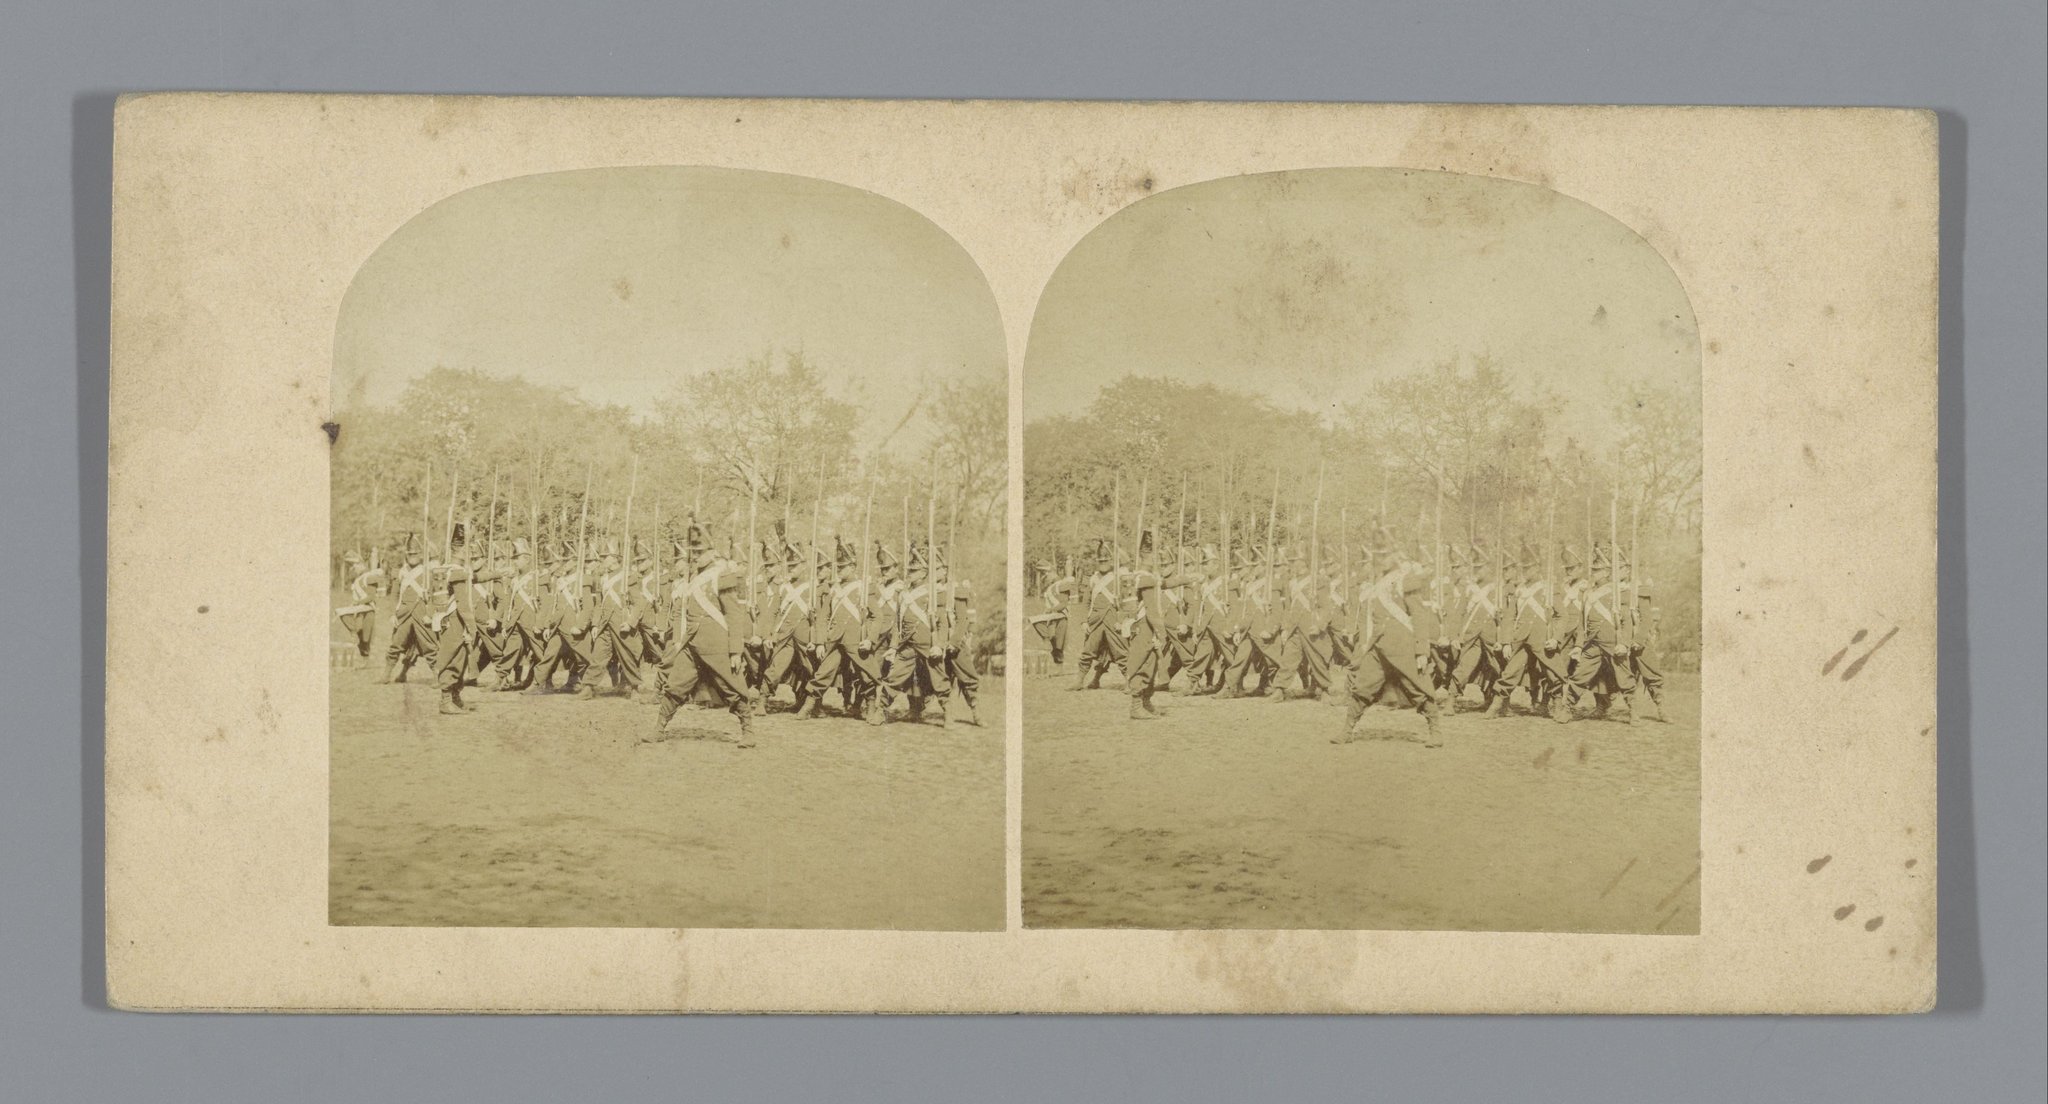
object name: stereograph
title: Marcherende Franse soldaten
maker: Anonymous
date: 1860-1880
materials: cardboard, photographic support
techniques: albumen print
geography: france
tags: marching away (troops), private soldier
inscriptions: number: ‘183’, inscription: ‘Marche oblique a bataille’